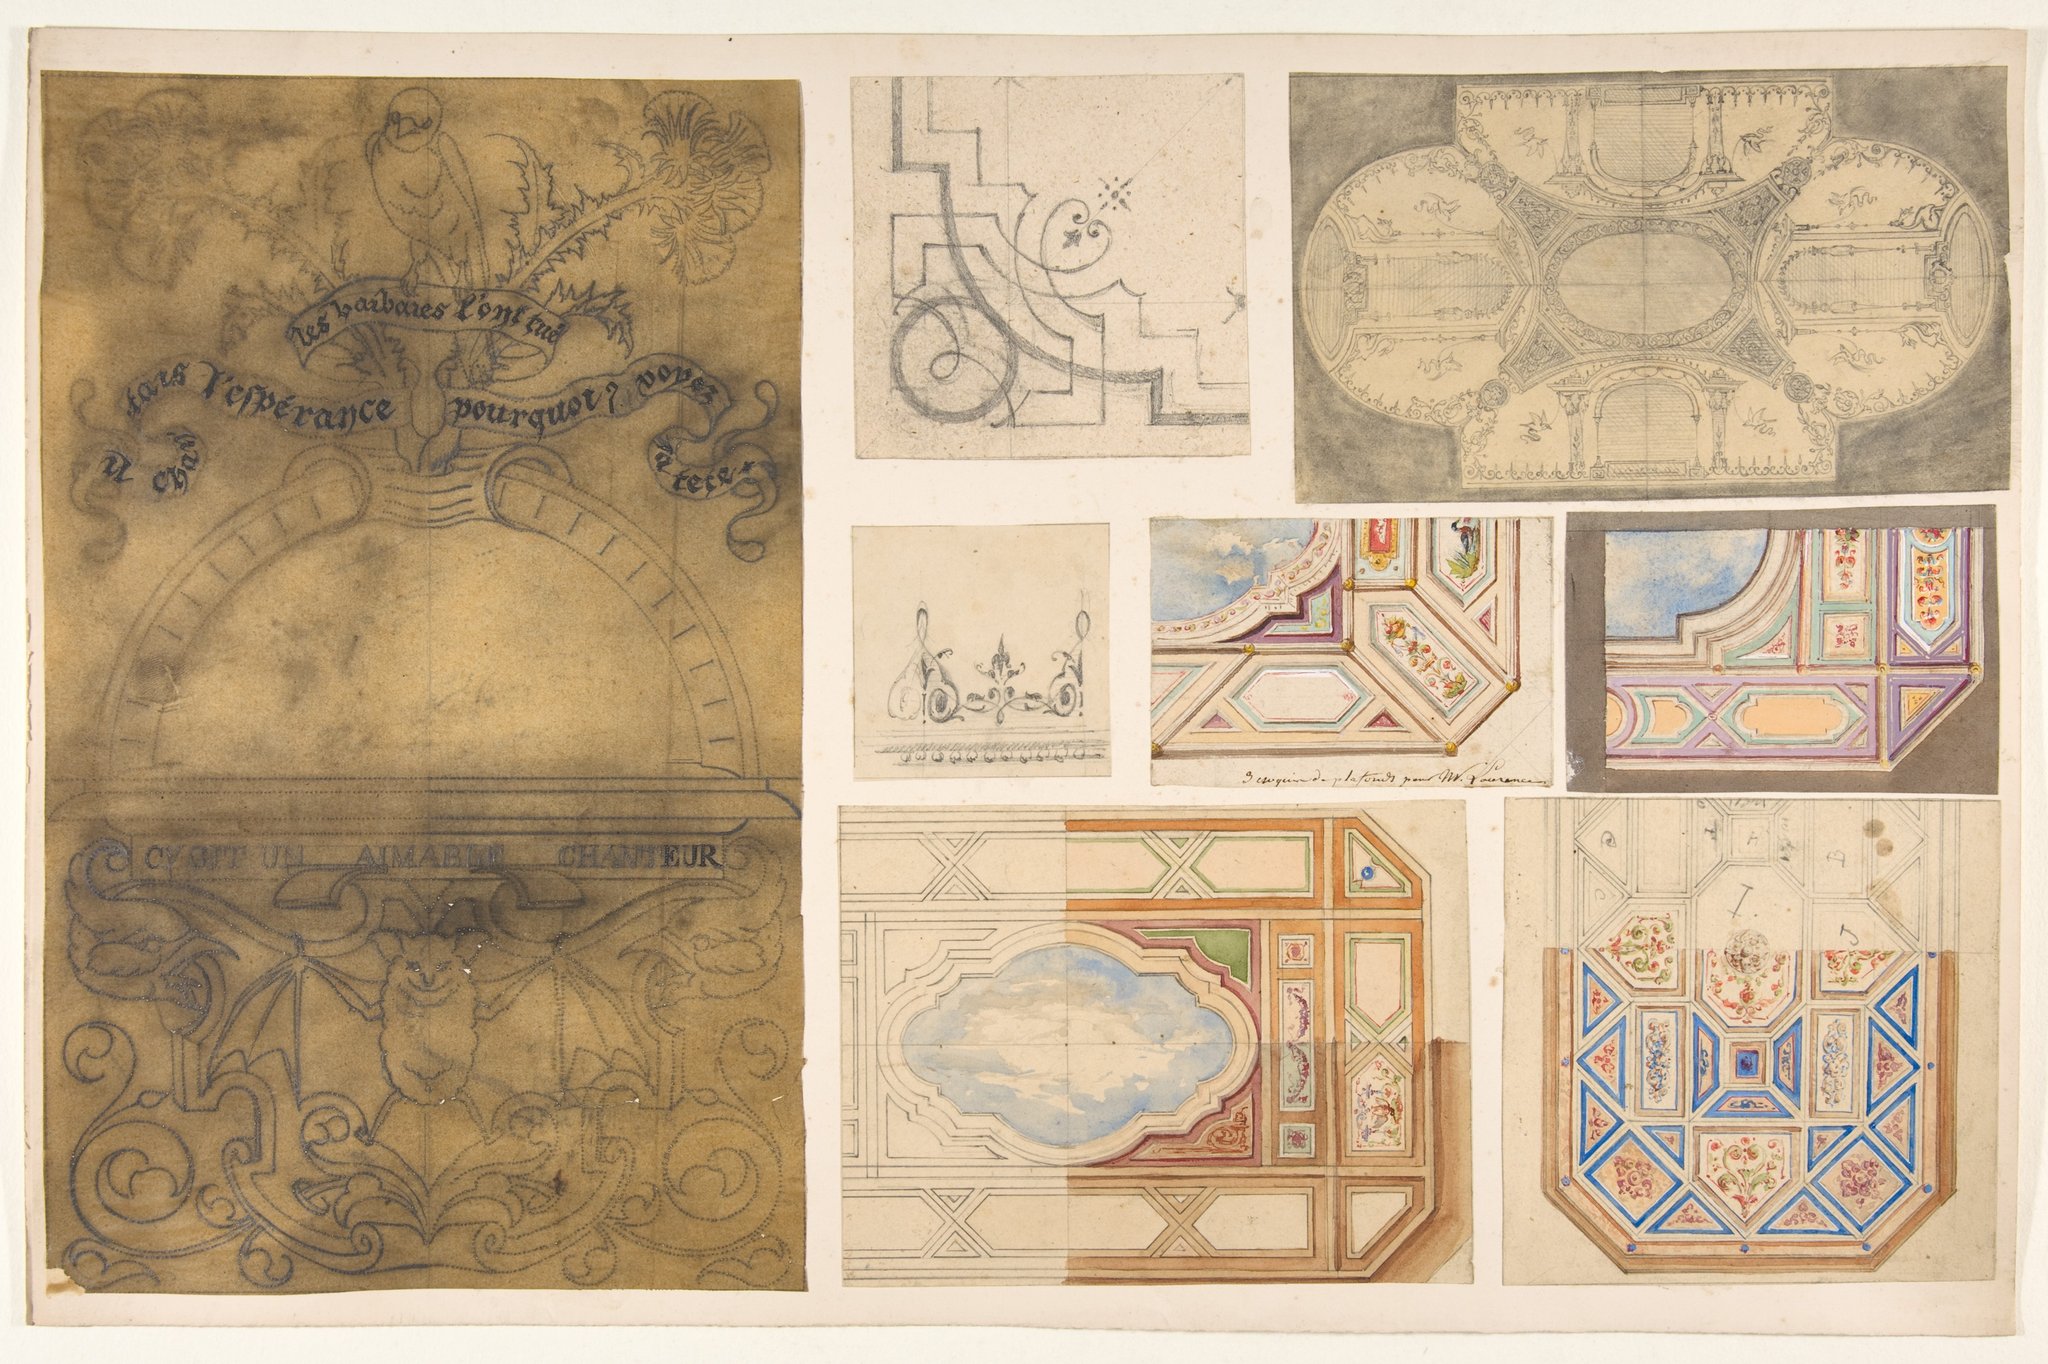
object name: drawing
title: Eight designs for a ceiling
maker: jules-edmond-charles lachaise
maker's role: artist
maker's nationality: french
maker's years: 1897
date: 1851-1900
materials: gouache, graphite, watercolor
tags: bats,birds,ceilings